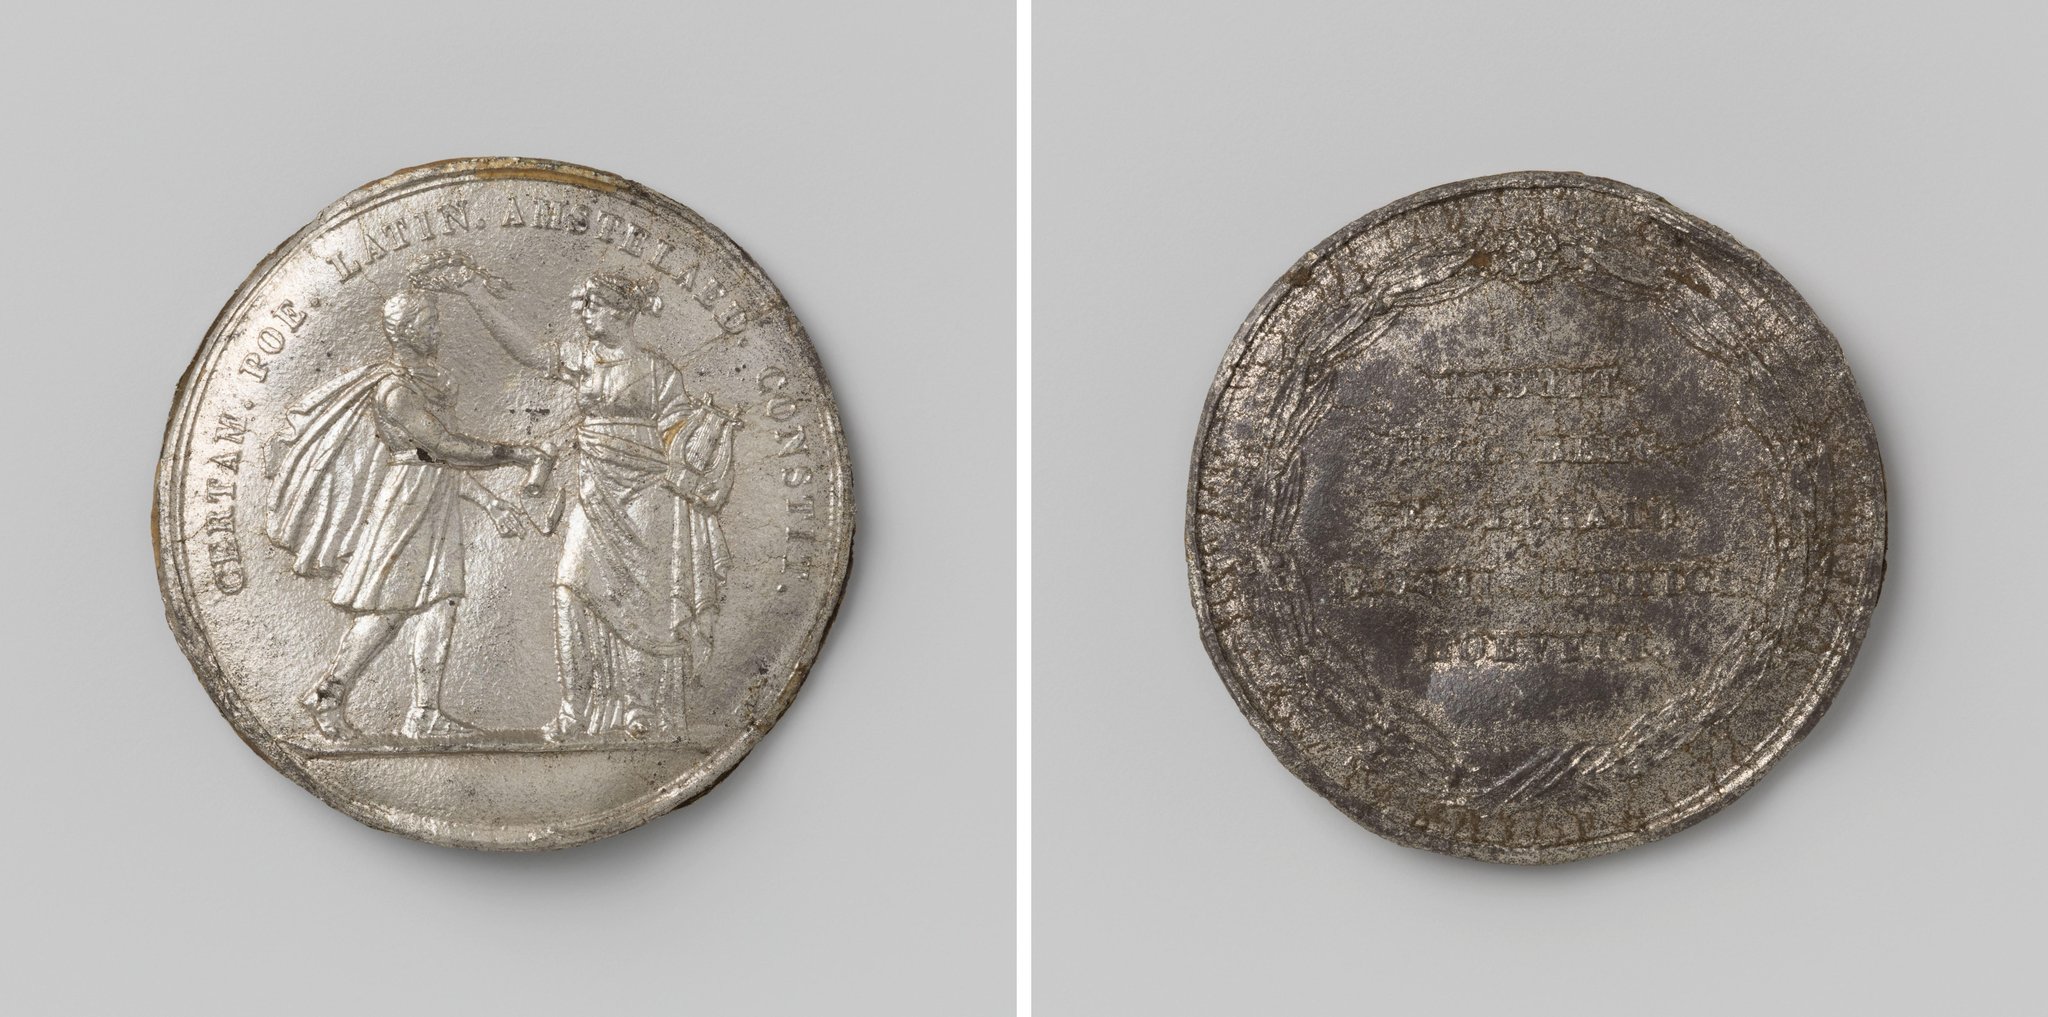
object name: cast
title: Legaat van J.H. Hoeufft ter bevordering van de beoefening der Latijnse poezie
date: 1843-1844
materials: wax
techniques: casting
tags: dordrecht, jacob hendrik hoeufft (1756-1843), amsterdam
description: Agietsel van een prijspenning in zilverpapier en was. Voorzijde: vrouw in antieke kledij, voorstellende Muze, houdt lier in linkerhand en kroont met lauwerkrans in uitgestrekte, geheven rechterhand een op haar toelopende man, die rol papier aanbiedt binnen omschrift. Keerzijde: opschrift binnen krans van olijftakken.